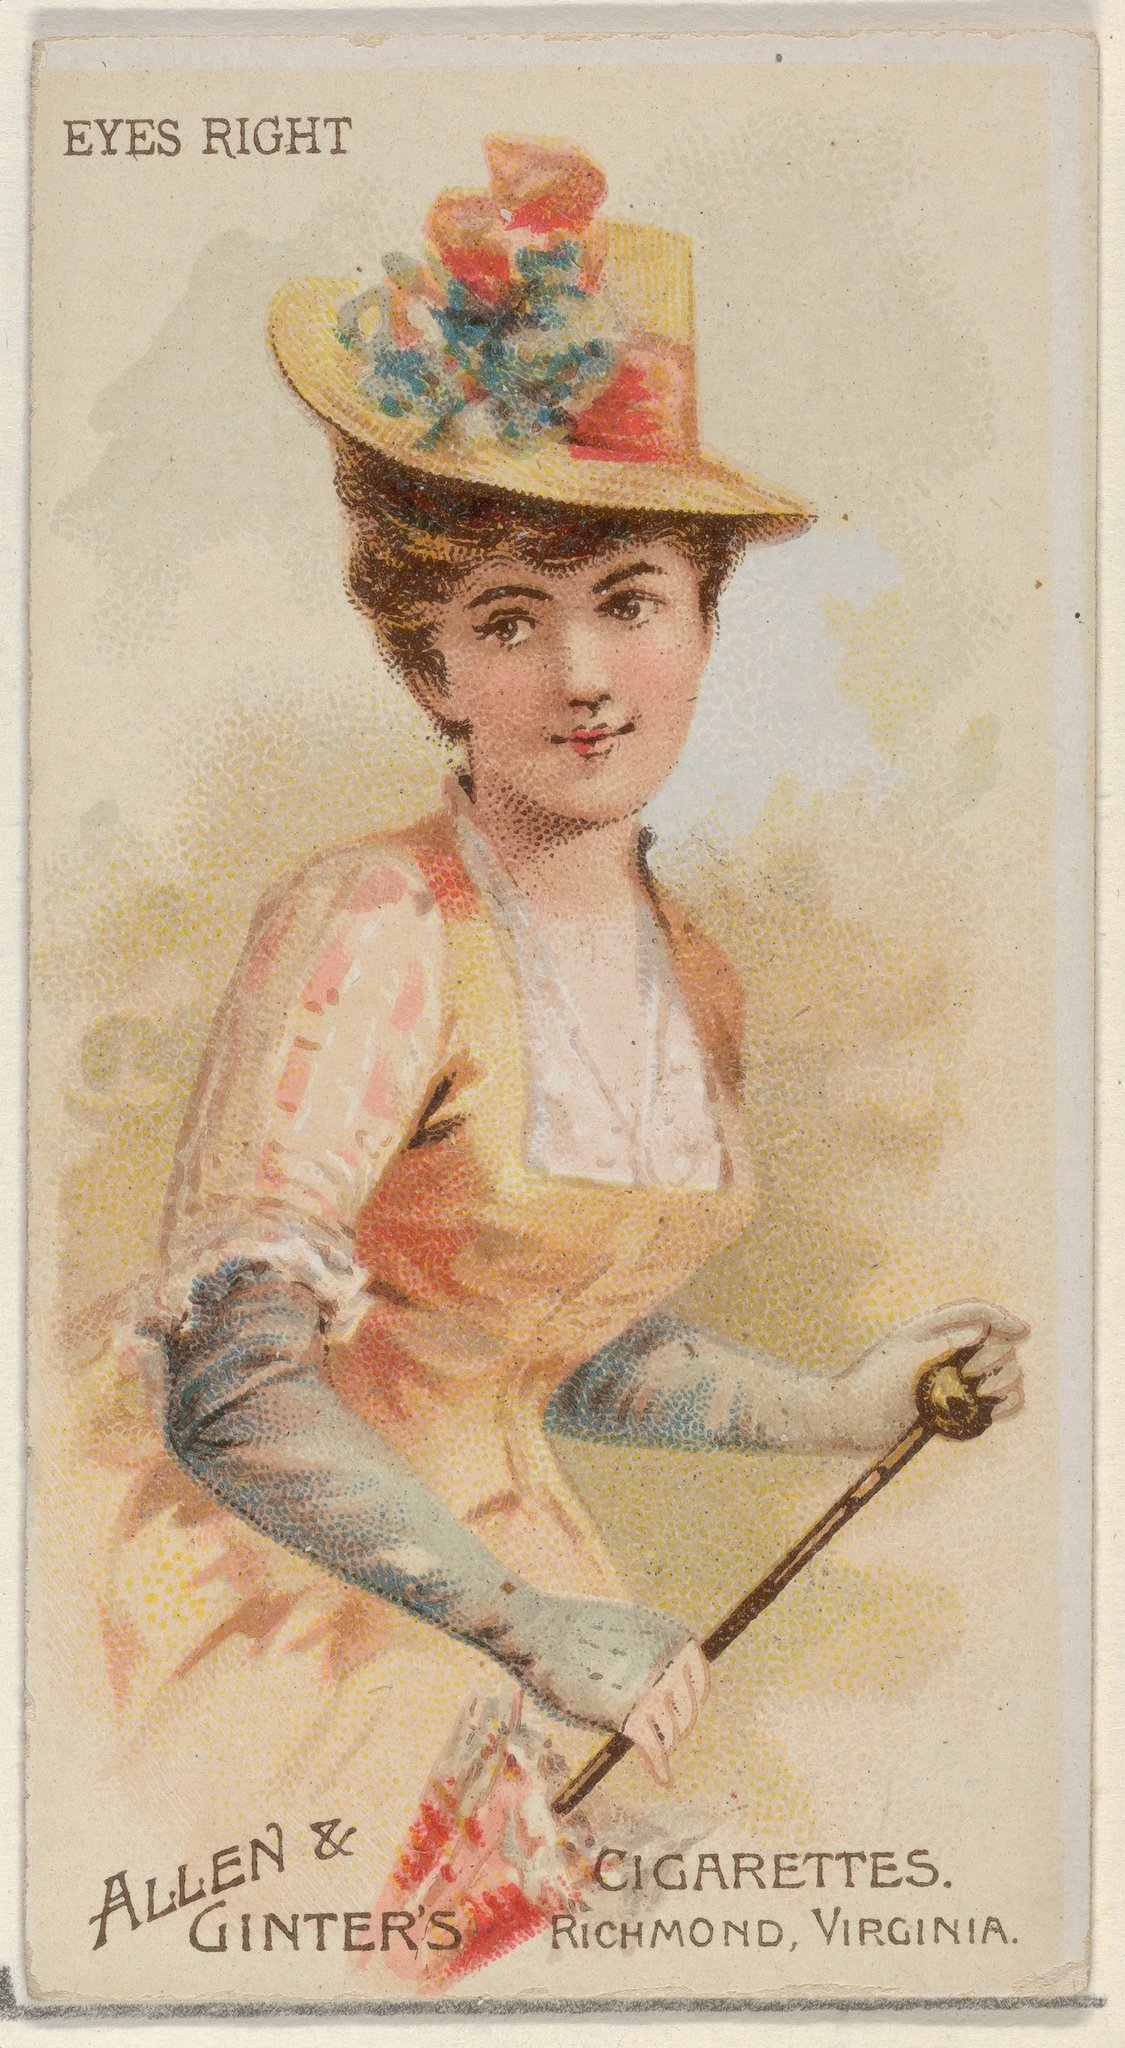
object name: print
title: Eyes Right, from the Parasol Drills series (N18) for Allen & Ginter Cigarettes Brands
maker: allen & ginter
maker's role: publisher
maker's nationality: american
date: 1888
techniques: color lithograph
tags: women